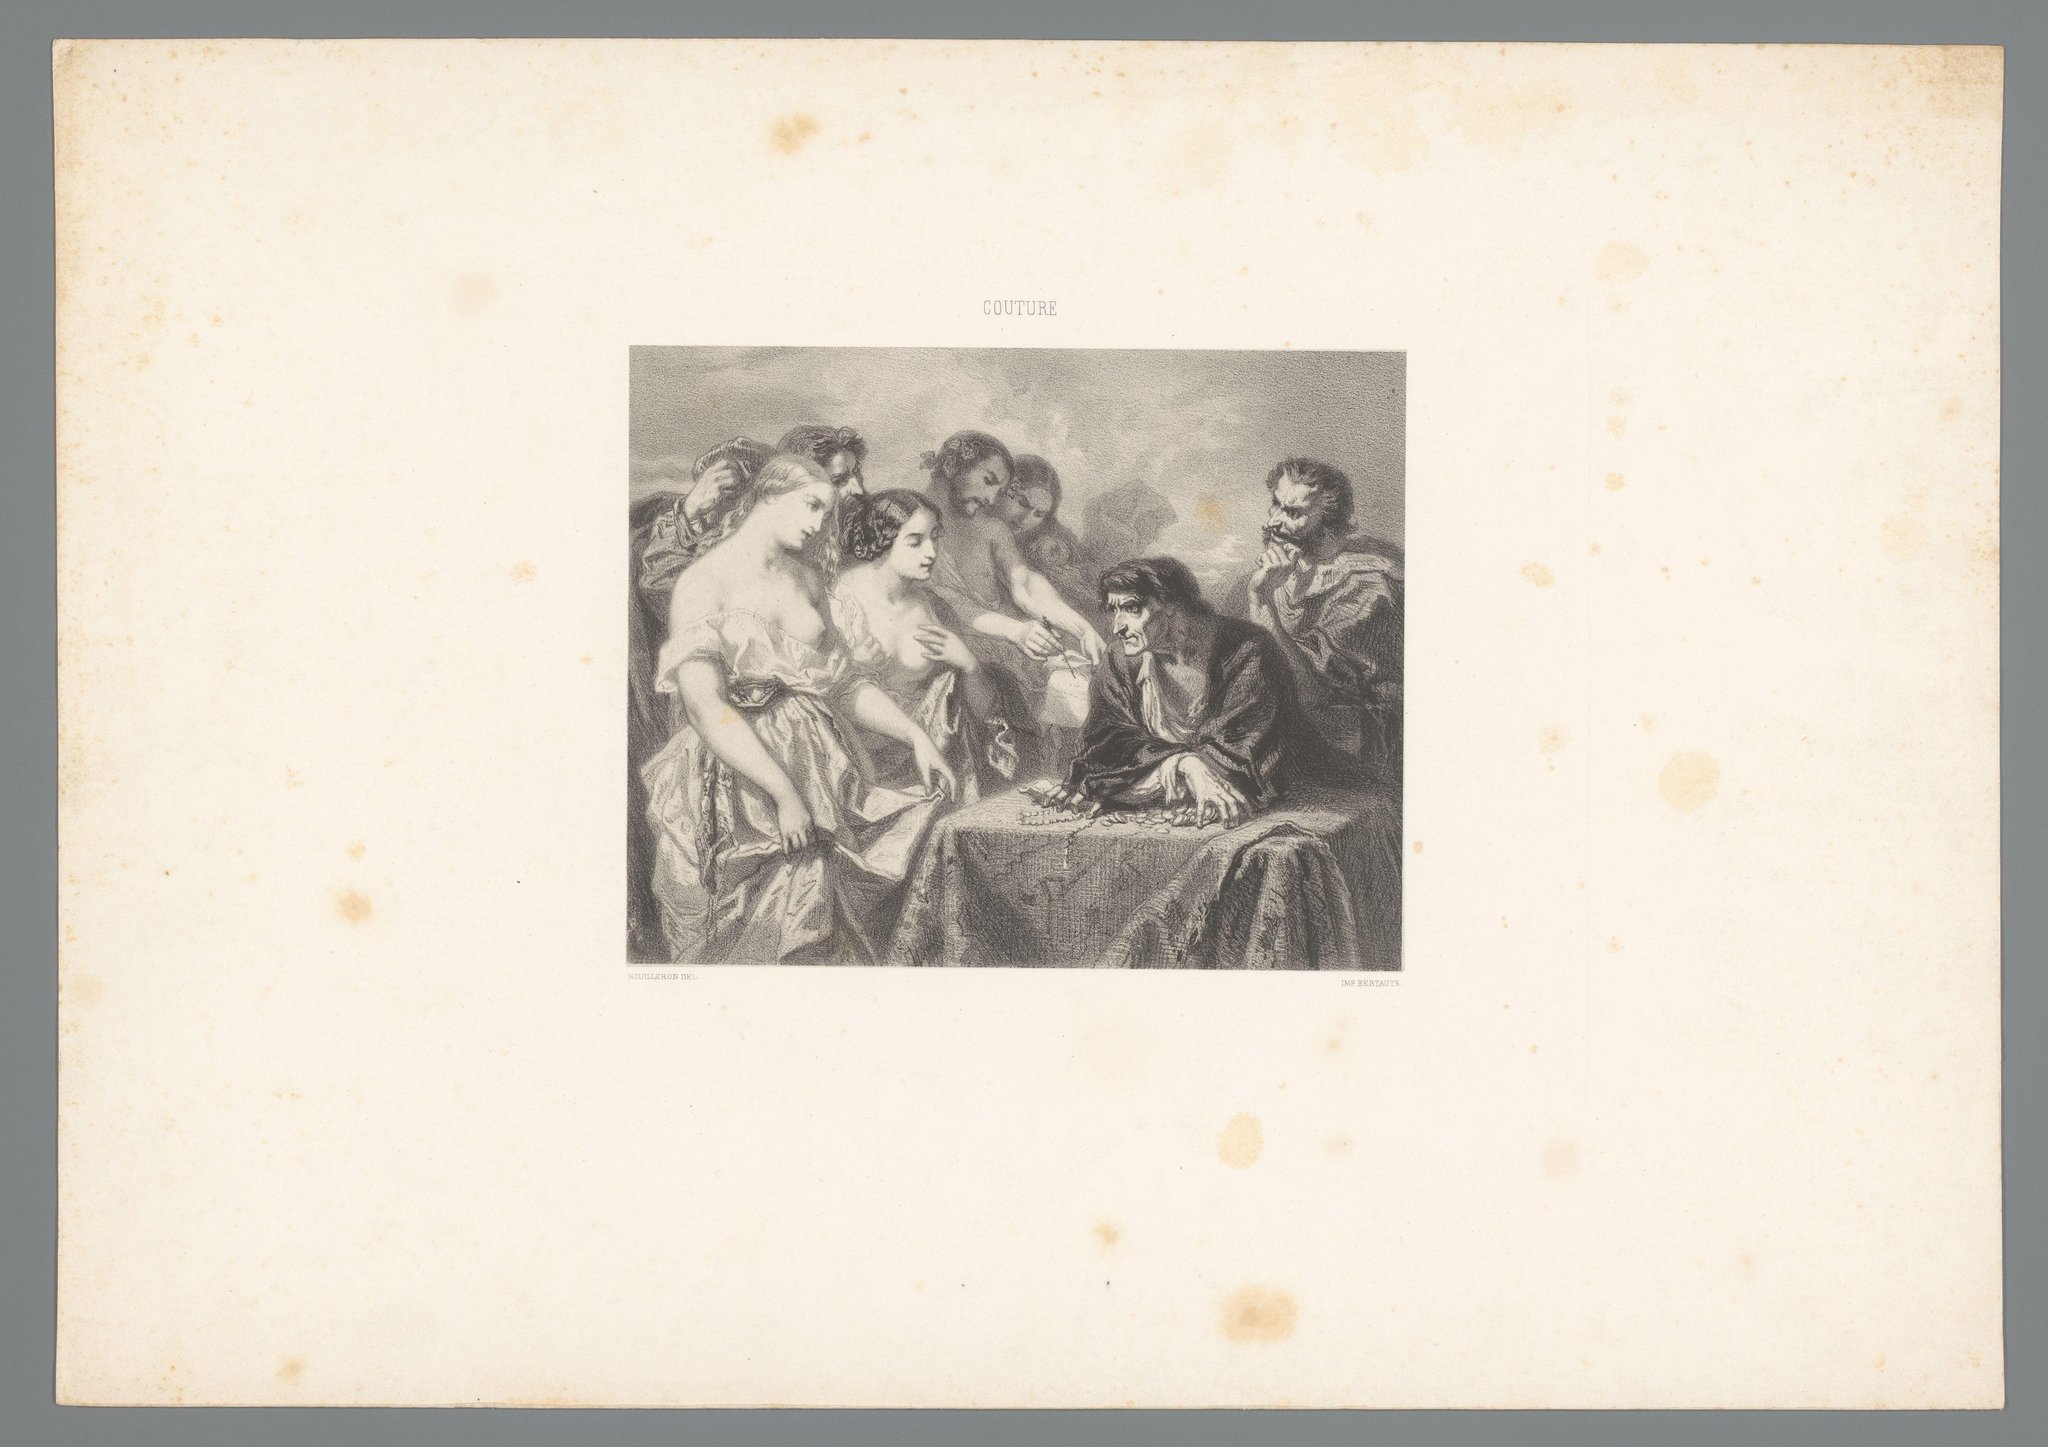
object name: print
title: Allegorie op de hebzucht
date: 1844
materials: paper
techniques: lithograph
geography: paris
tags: money-lender, usurer, fashion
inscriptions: collector's mark: Lugt 964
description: Latere staat van prent verschenen in: Les Beaux-Arts. Illustration des arts et de la littérature. Deel 3. Parijs: Léon Curmer, 1844.